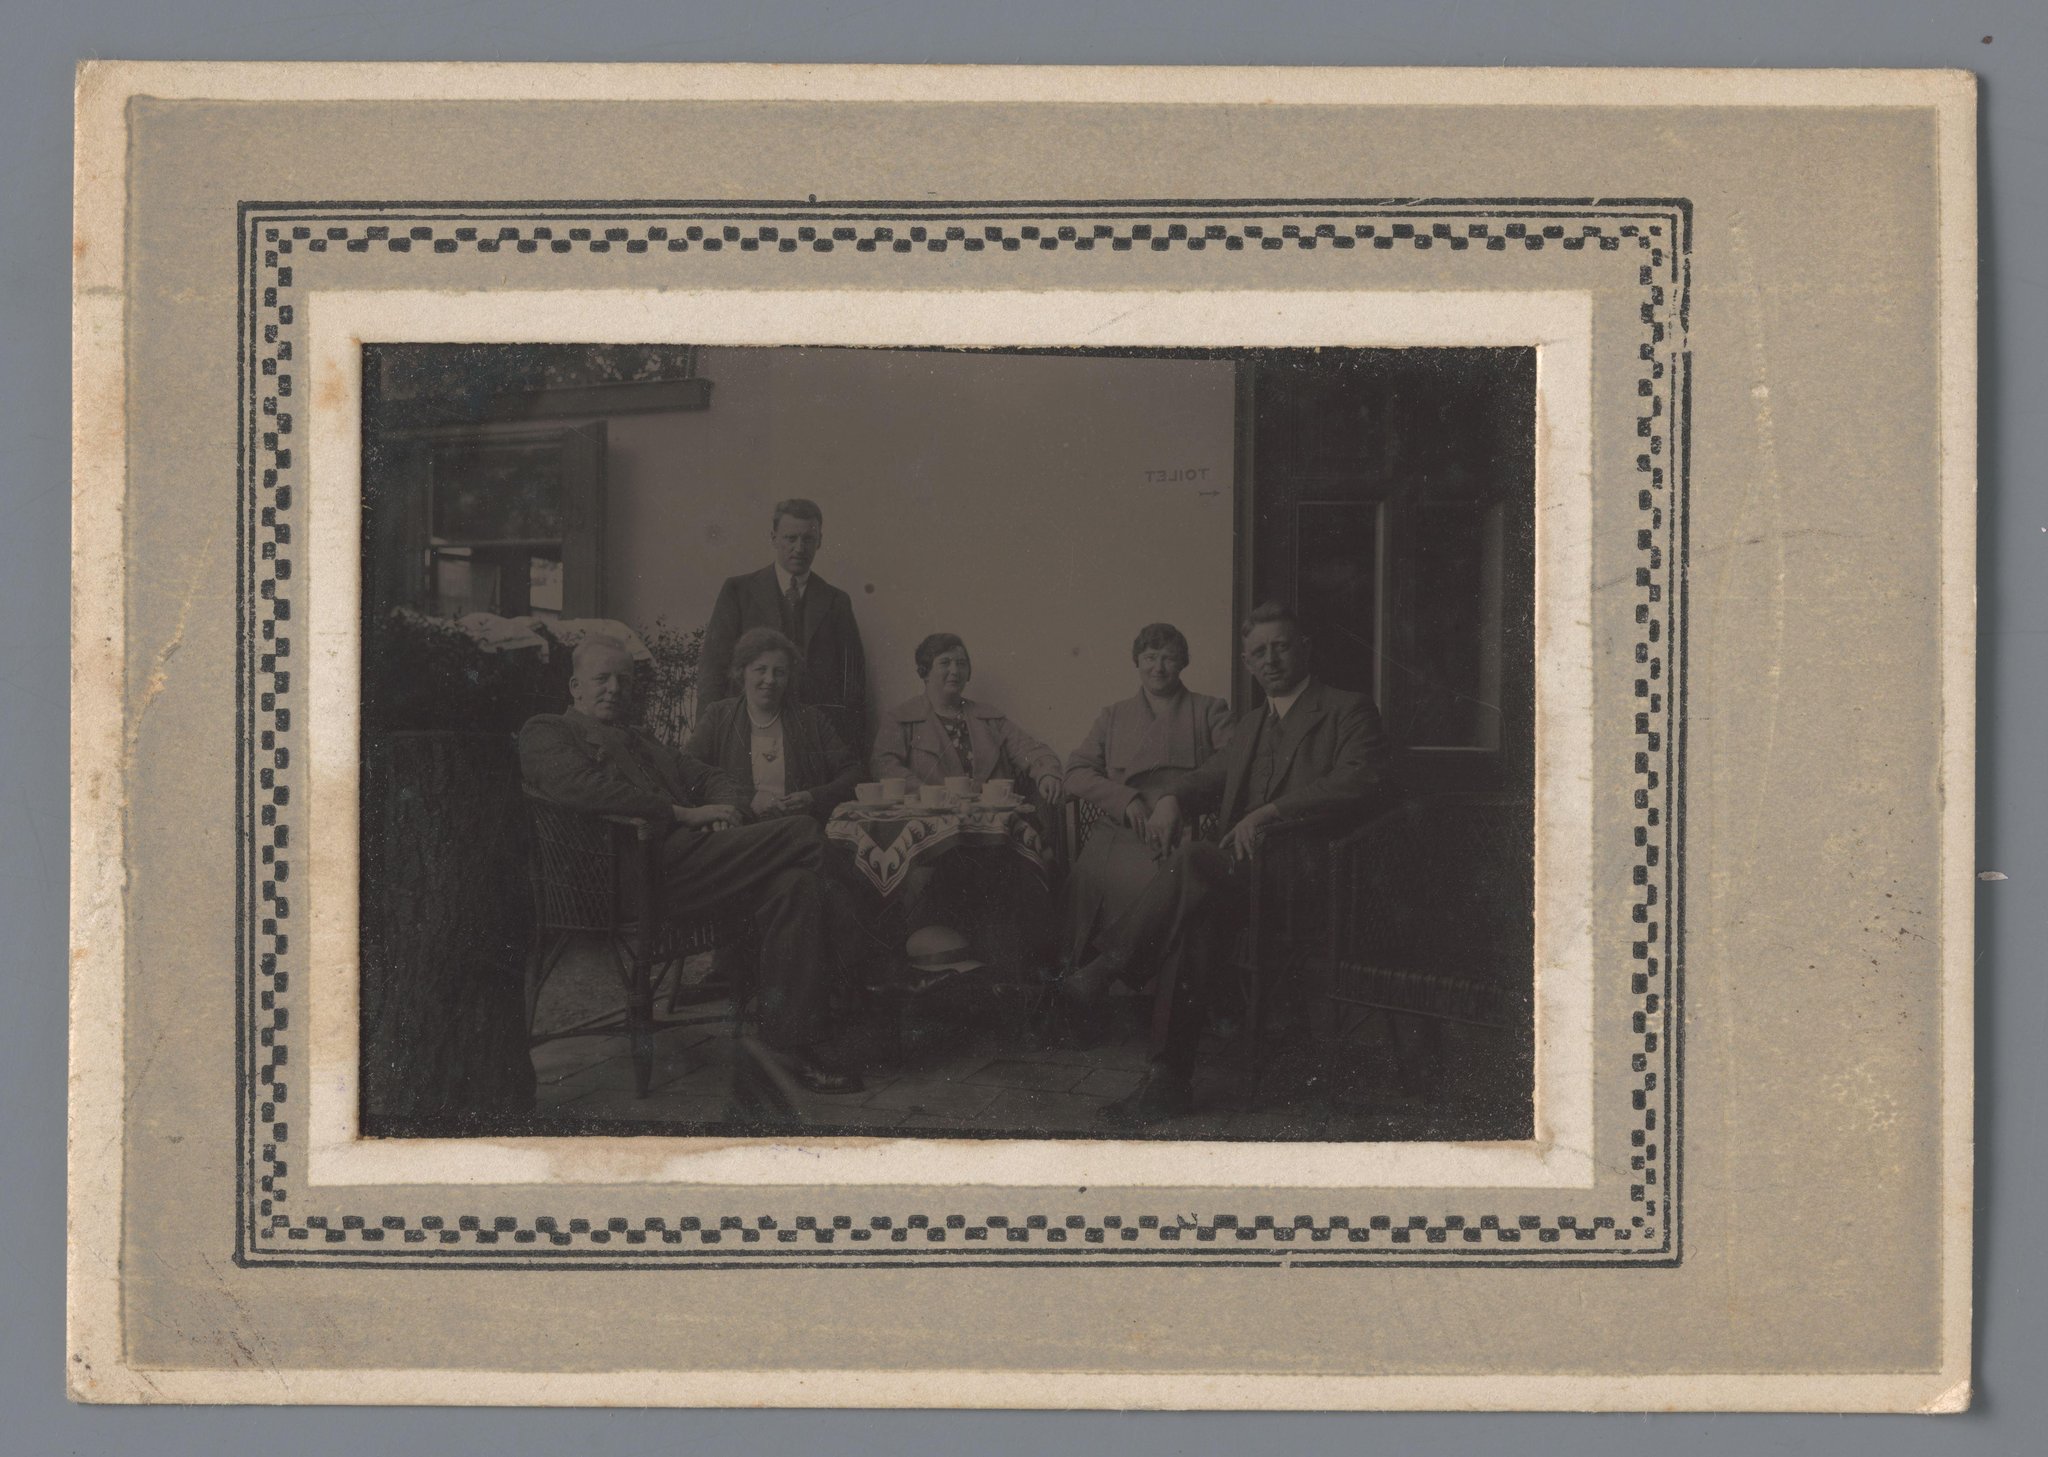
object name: photograph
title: Familieportret in een café Flora te Doorn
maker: Anonymous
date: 1855-1940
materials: cardboard, iron, paper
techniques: ferrotyping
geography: doorn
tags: anonymous historical persons portrayed in a group, in a group-portrait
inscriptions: inscription: ‘Café-Rest. Flora/ Doorn’